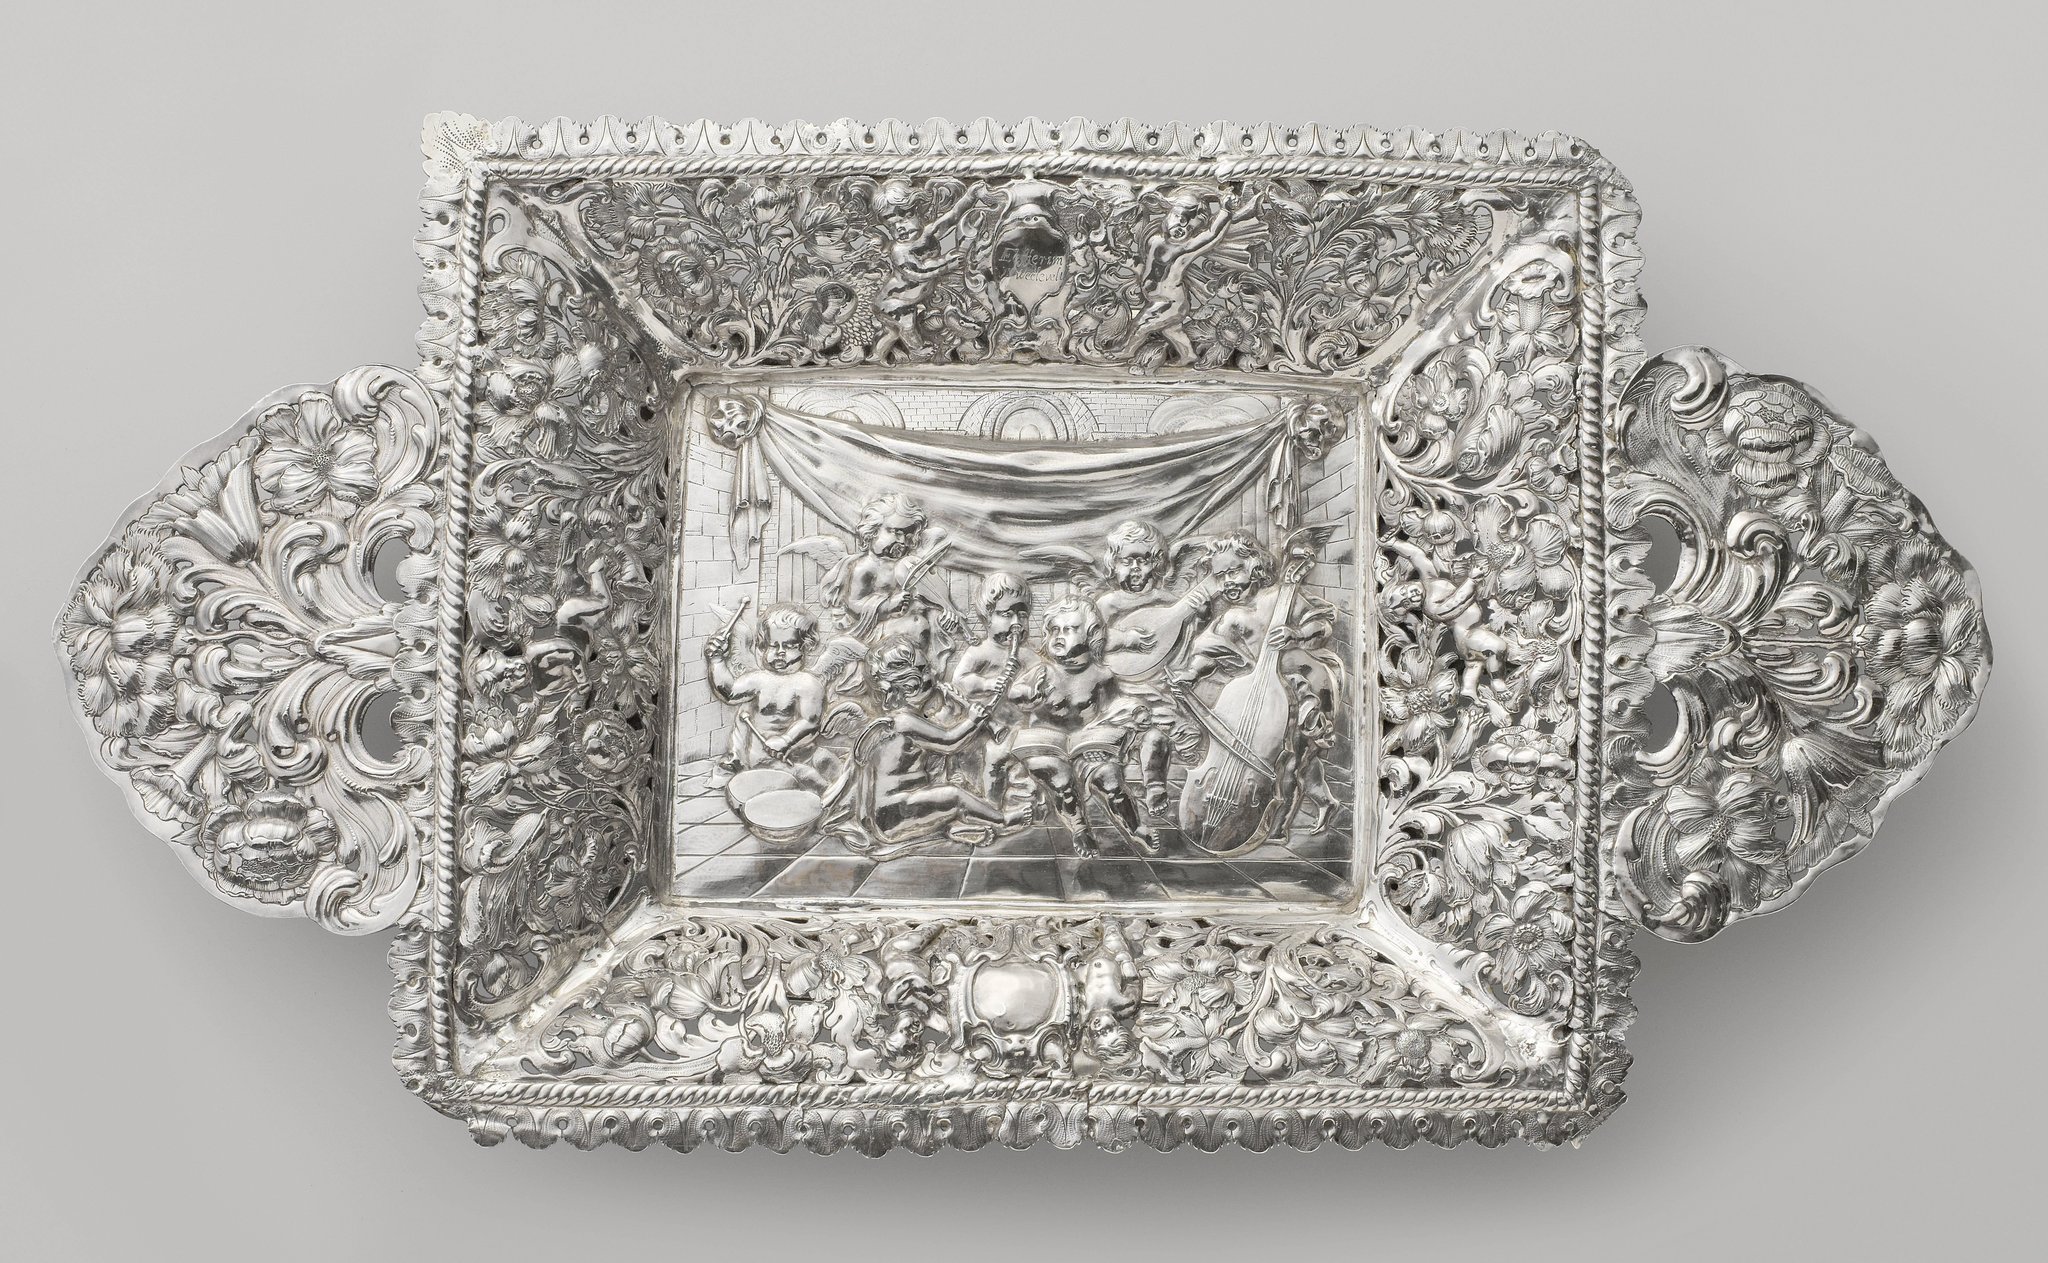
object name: luiermand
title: Luiermand met een voorstelling van musicerende putti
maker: gerloff brouwer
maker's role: silversmith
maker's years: 1627-1676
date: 1660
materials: iron, silver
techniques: repoussé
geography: amsterdam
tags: musician(s) accompanying singer(s), cupids: 'amores', 'amoretti', 'putti', ornament derived from plant forms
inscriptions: inscription: ‘Eefferim V:Weelevelt’, mark, date letter: ‘H’, maker's mark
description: Layette basket. Silver. Probably Amsterdam, 1660 maker's mark G B.